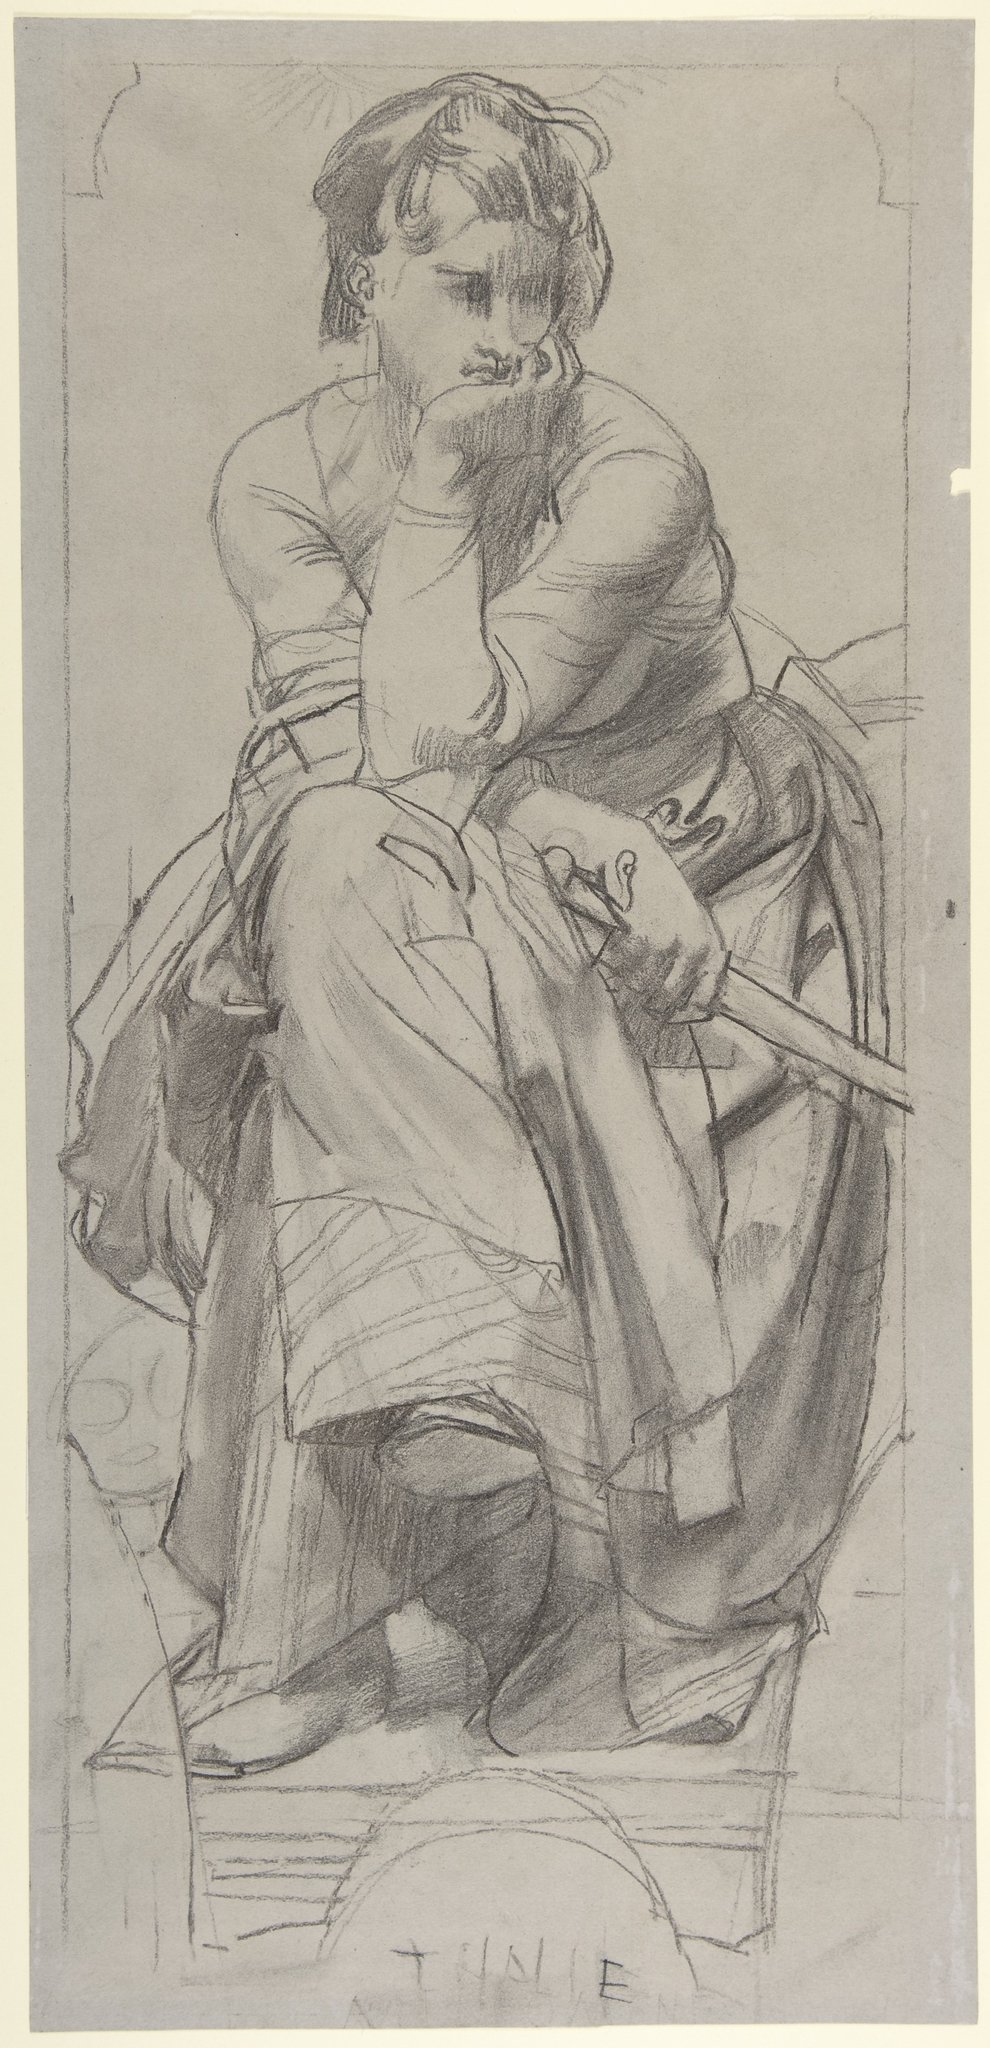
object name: drawing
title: Study for the Muse Thalia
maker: paul baudry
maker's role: artist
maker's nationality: french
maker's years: 1828-1886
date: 1801-1900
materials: chalk, paper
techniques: stumping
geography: france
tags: contemplation,women,muses